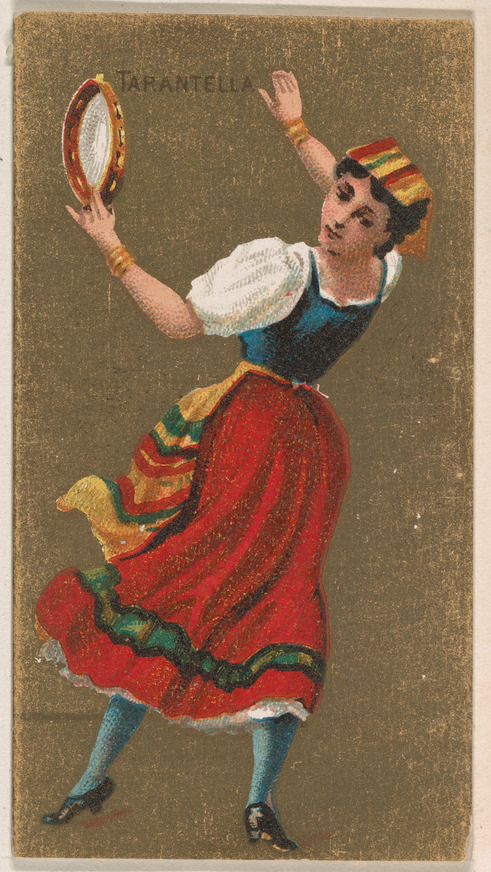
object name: print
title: Tarantella, from National Dances (N225, Type 2) issued by Kinney Bros.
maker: kinney brothers tobacco company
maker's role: publisher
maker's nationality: american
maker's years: 1869-2011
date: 1889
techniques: color lithograph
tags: women,dancers